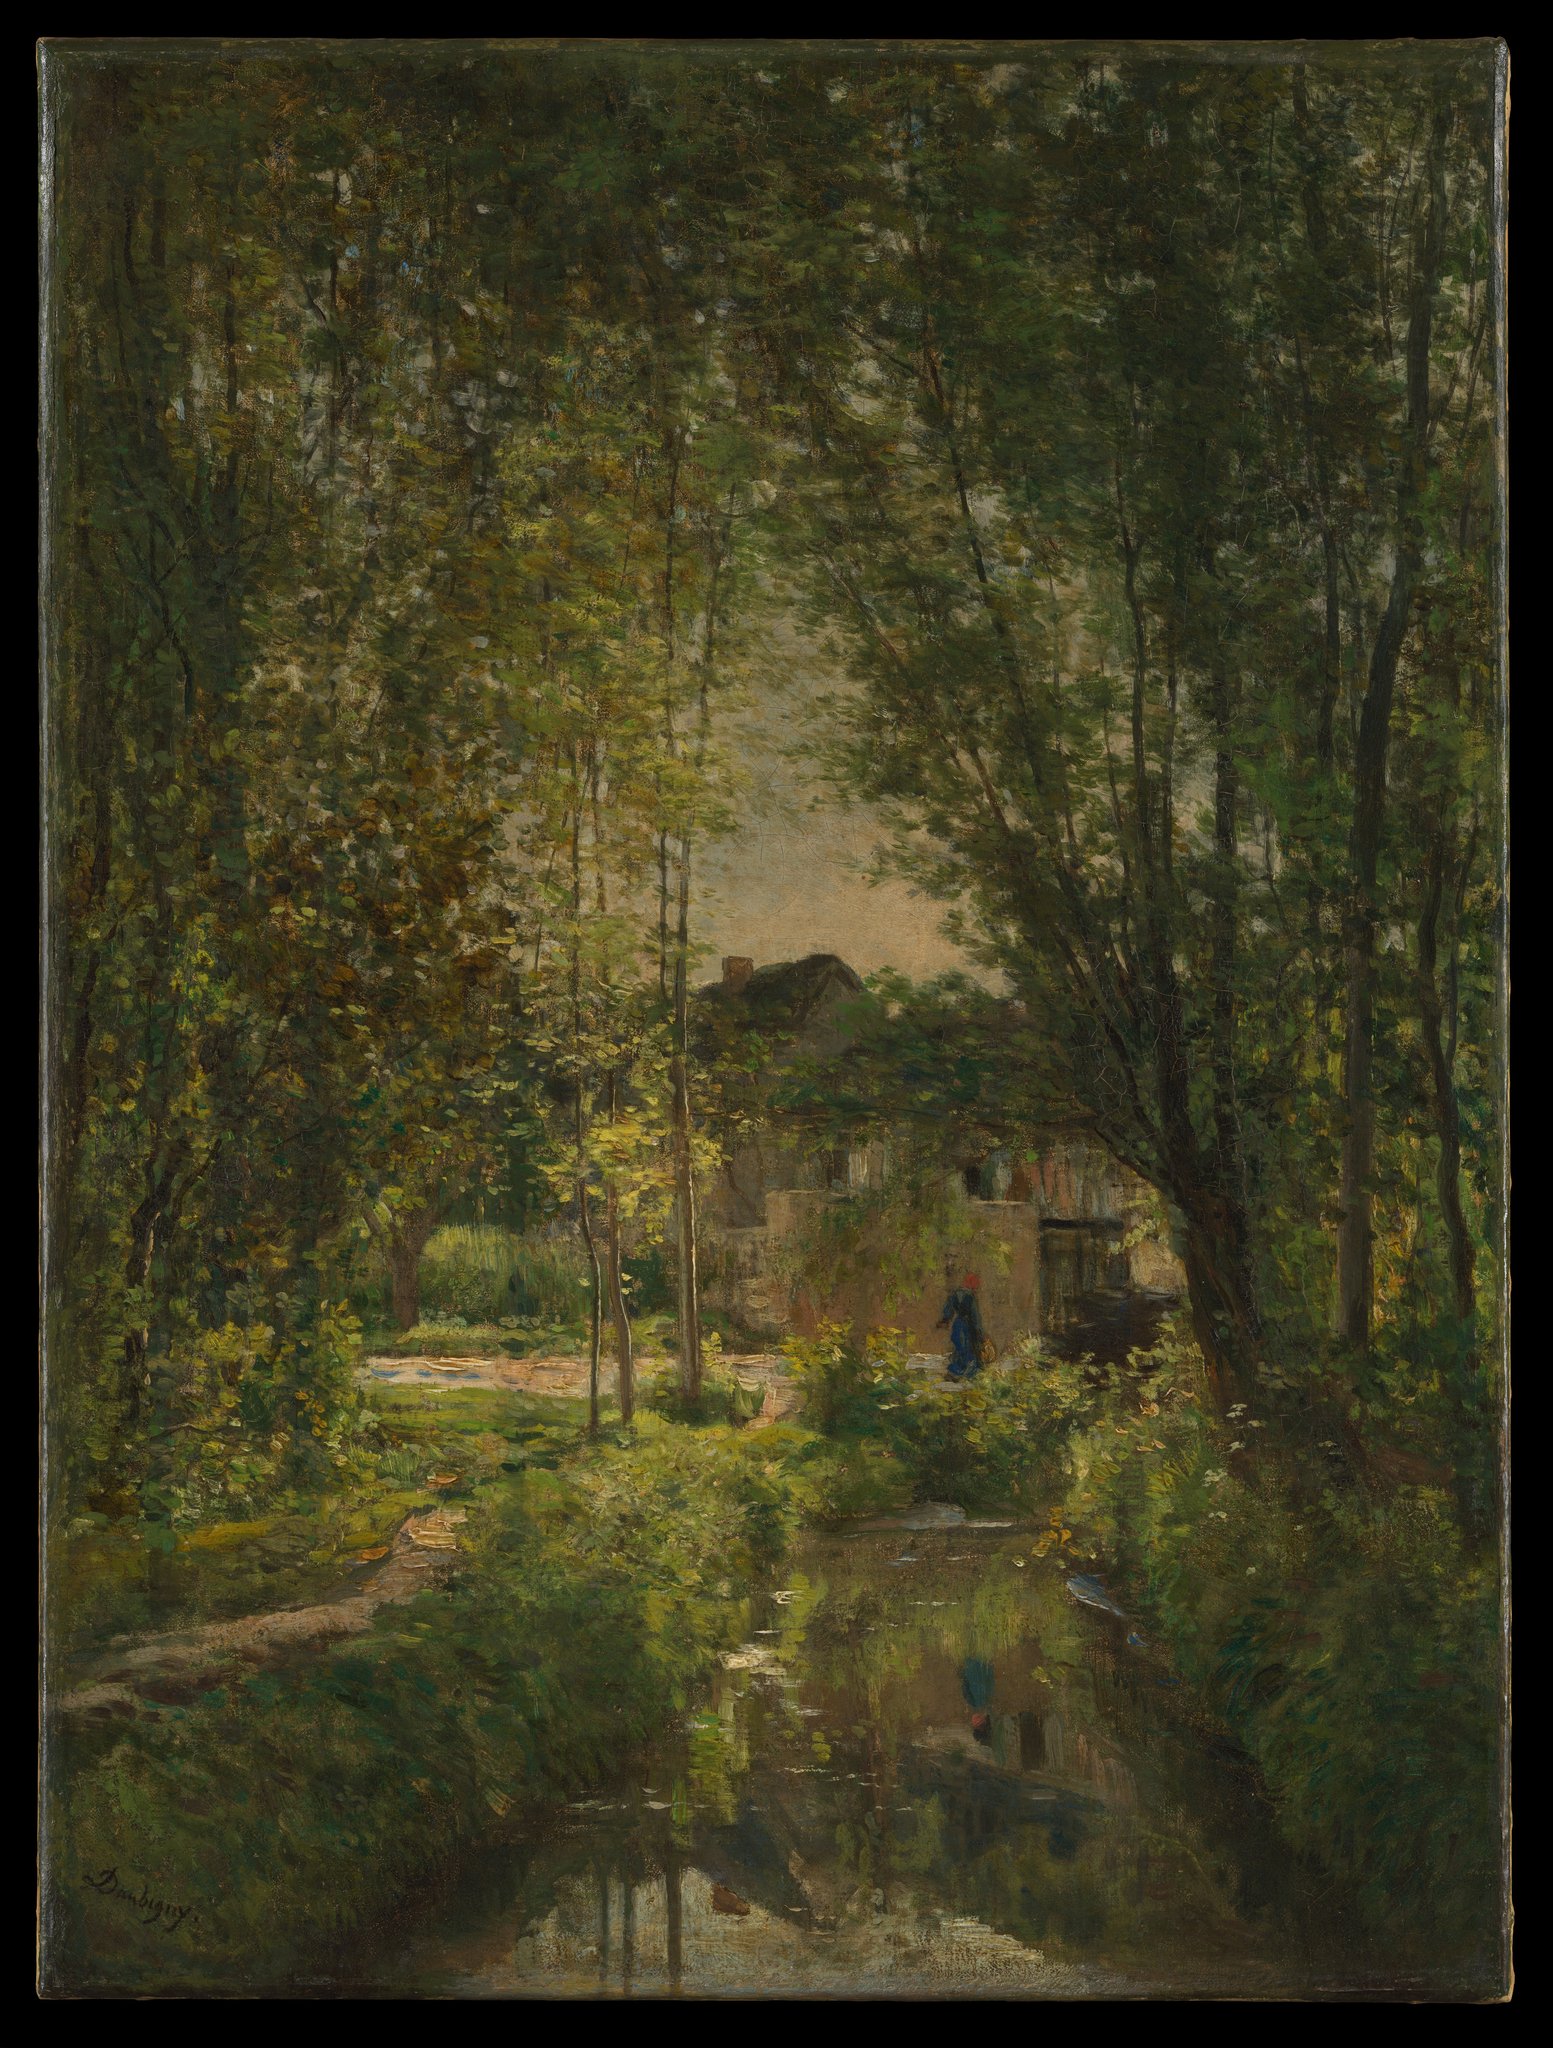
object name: painting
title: Landscape with a Sunlit Stream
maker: charles-françois daubigny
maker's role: artist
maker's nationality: french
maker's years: 1817-1878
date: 1877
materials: canvas, oil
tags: forests,landscapes,streams